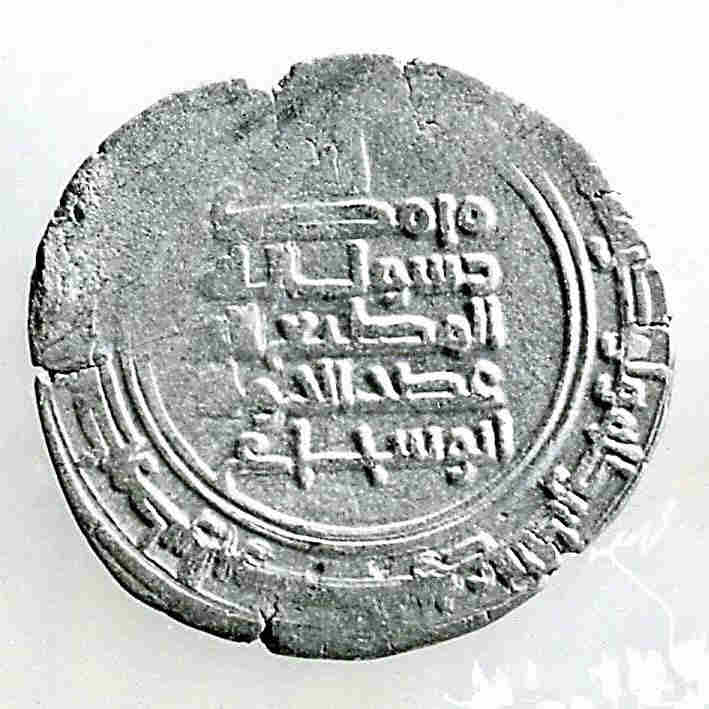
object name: coin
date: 949-976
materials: silver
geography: iran